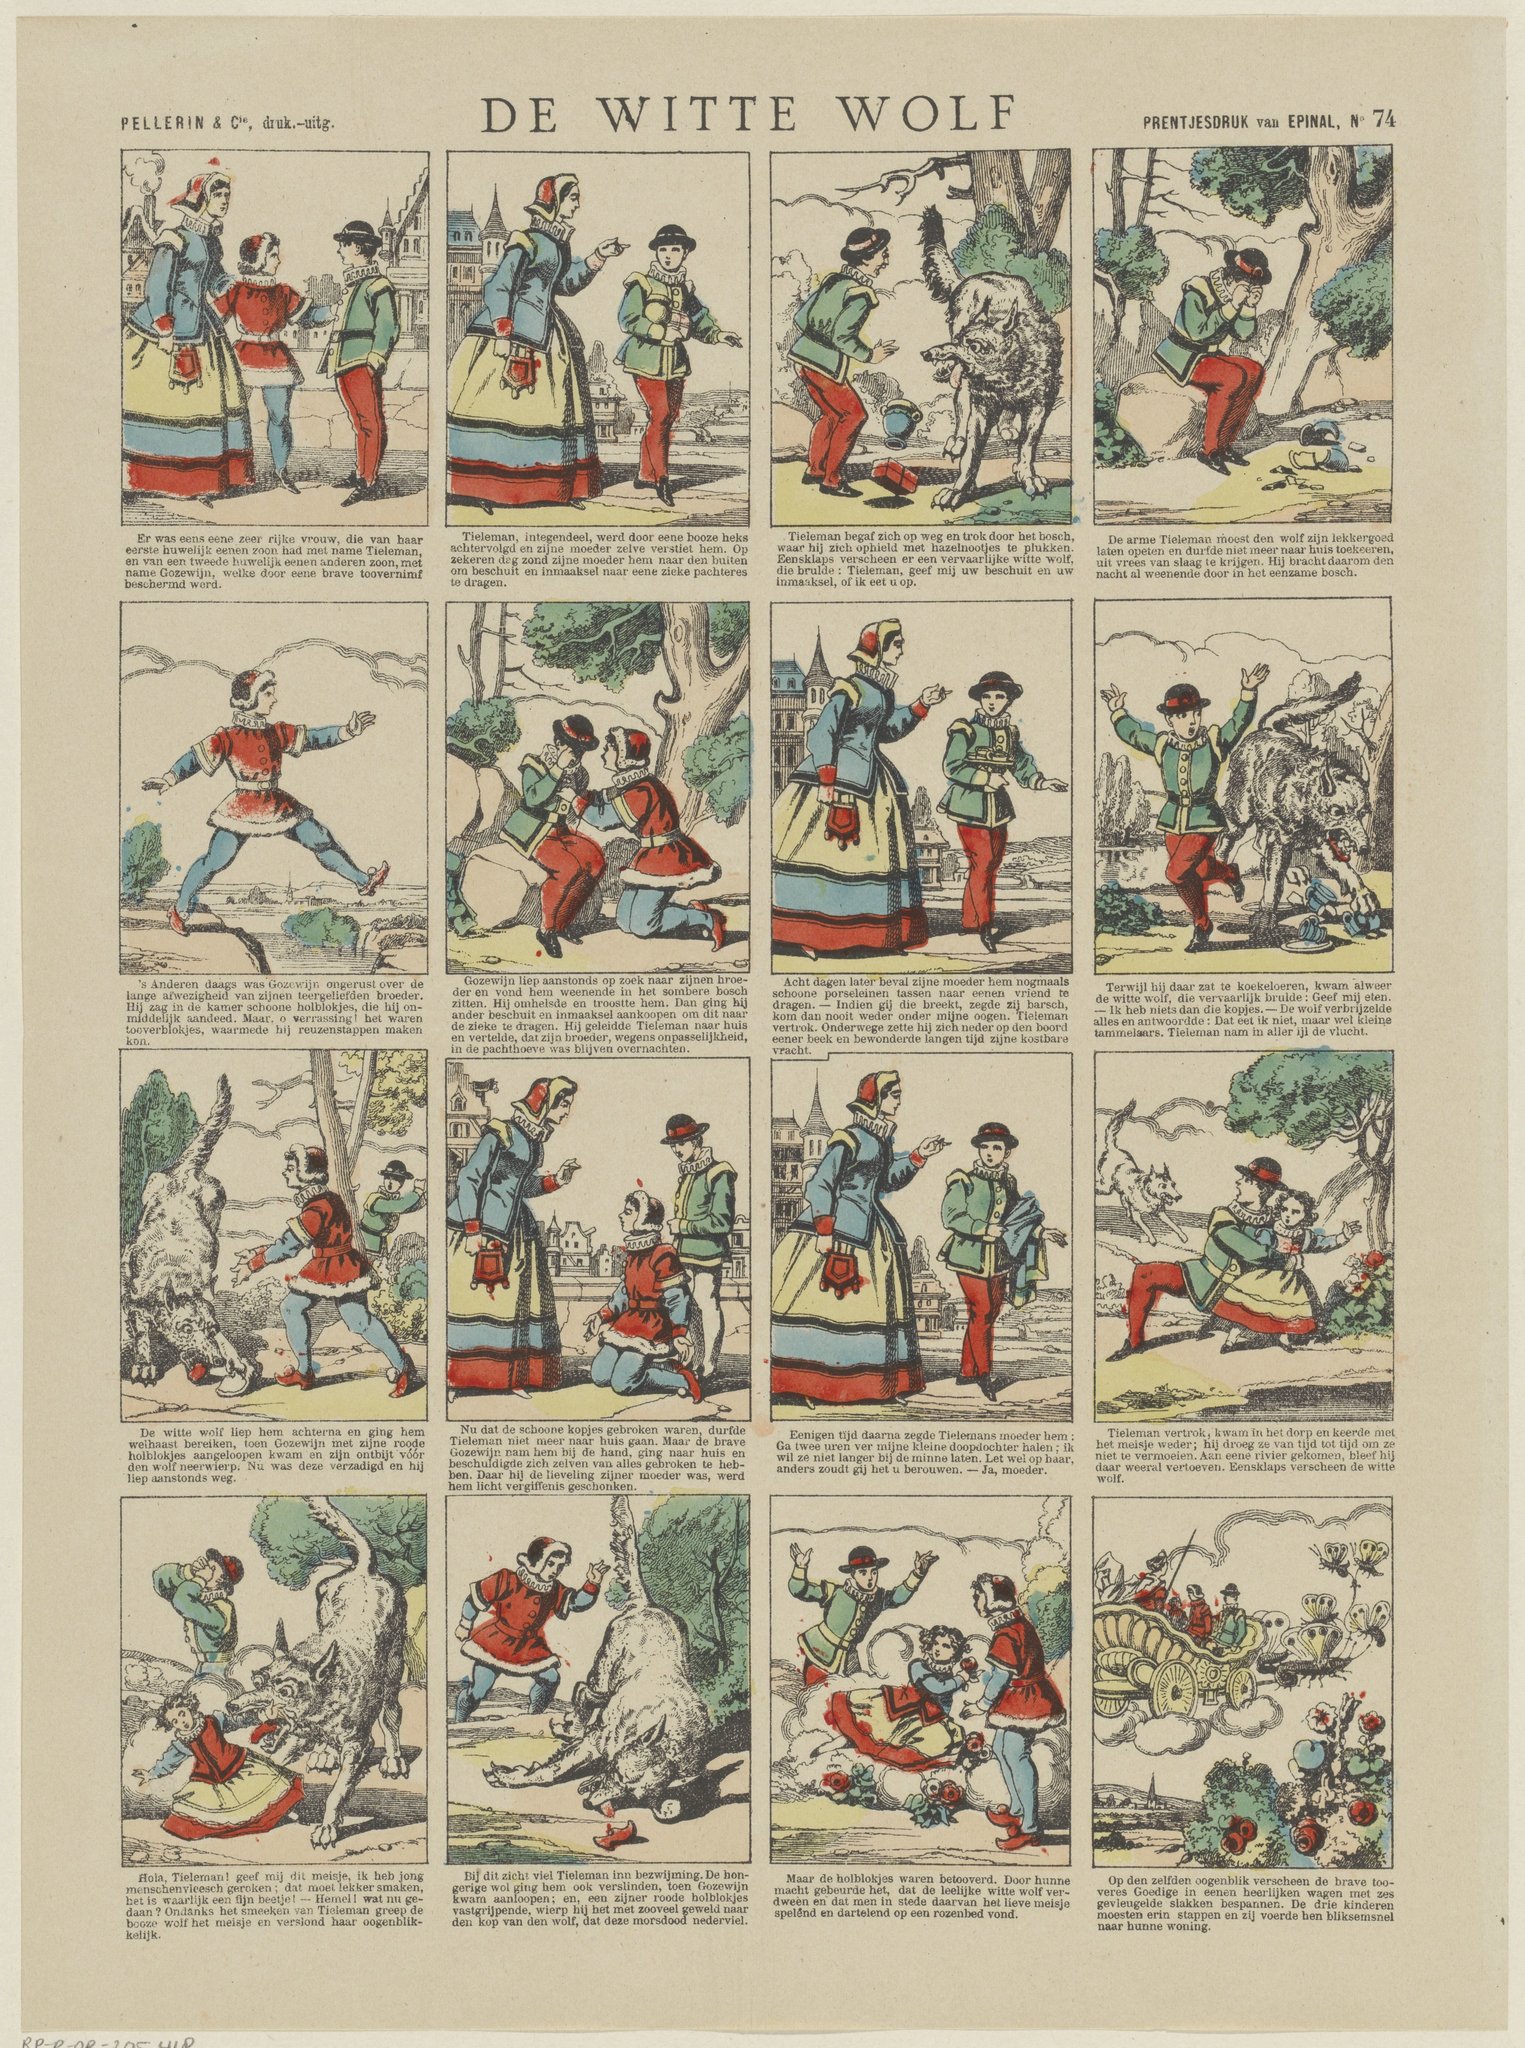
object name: print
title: Prentjesdruk van Épinal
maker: Anonymous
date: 1902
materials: paper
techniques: colour, letterpress printing, lithograph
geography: epinal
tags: tales and fairy tales, beasts of prey, predatory animals: wolf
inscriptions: collector's mark: Lugt 2760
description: Blad met 16 voorstellingen uit het sprookje van de witte wolf. Onder elke afbeelding een onderschrift. Genummerd rechtsboven: No 74.